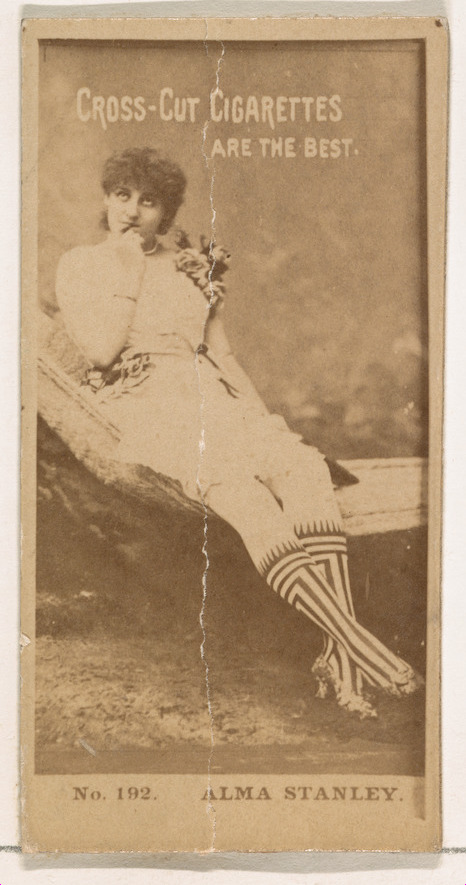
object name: print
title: Card Number 192, Alma Stanley, from the Actors and Actresses series (N145-2) issued by Duke Sons & Co. to promote Cross Cut Cigarettes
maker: w. duke, sons & co.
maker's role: publisher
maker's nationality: american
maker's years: 1870-1920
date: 1880-1889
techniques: albumen silver print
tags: portraits,women,actresses